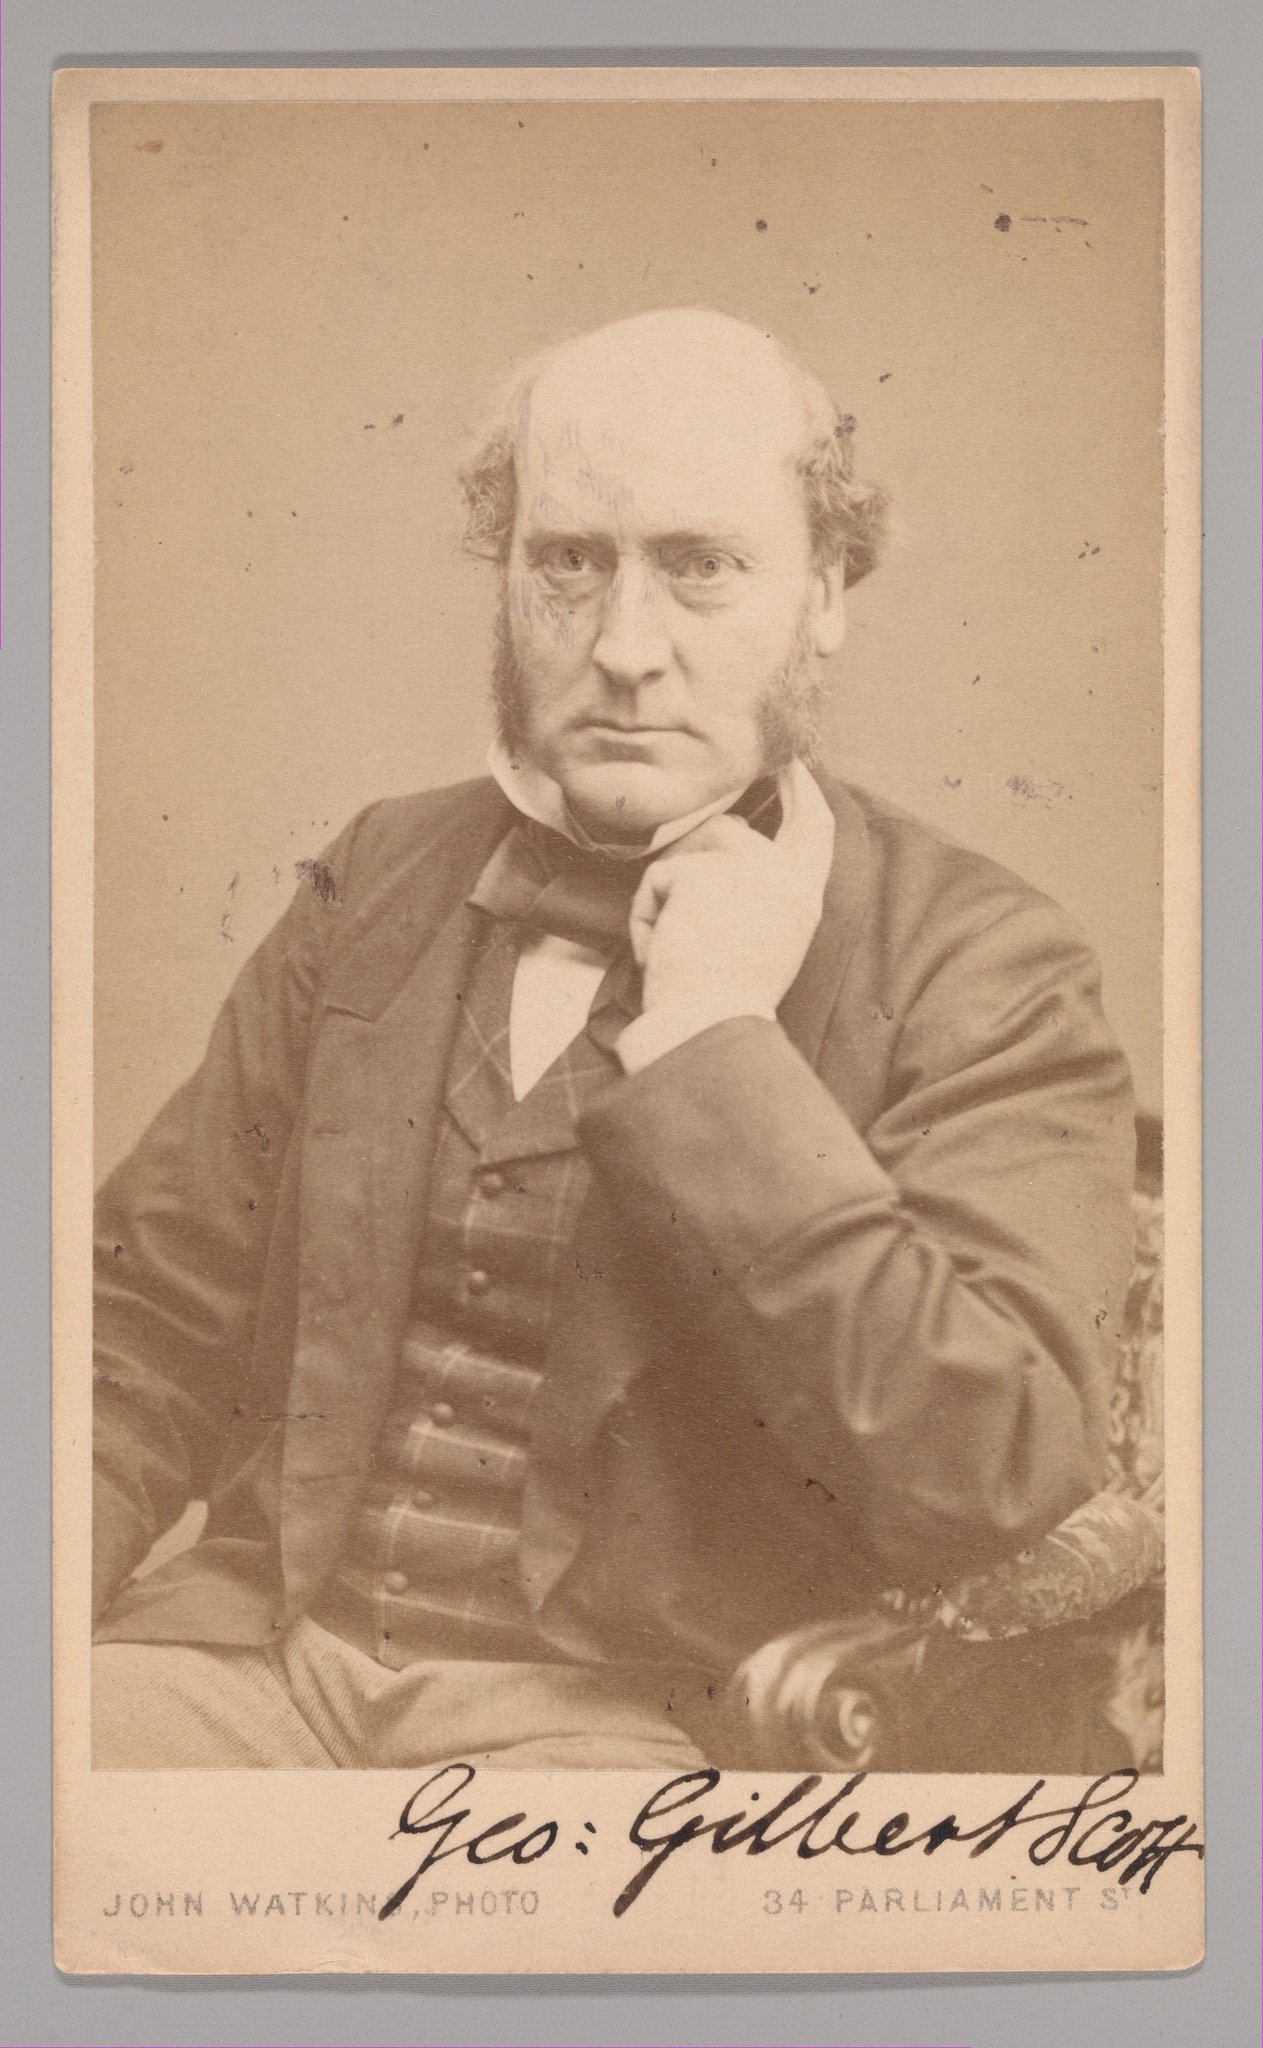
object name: carte de visite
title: [George Gilbert Scott]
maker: john and charles watkins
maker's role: photography studio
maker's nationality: british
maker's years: 1840-1875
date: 1860-1869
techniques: albumen silver print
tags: men,portraits